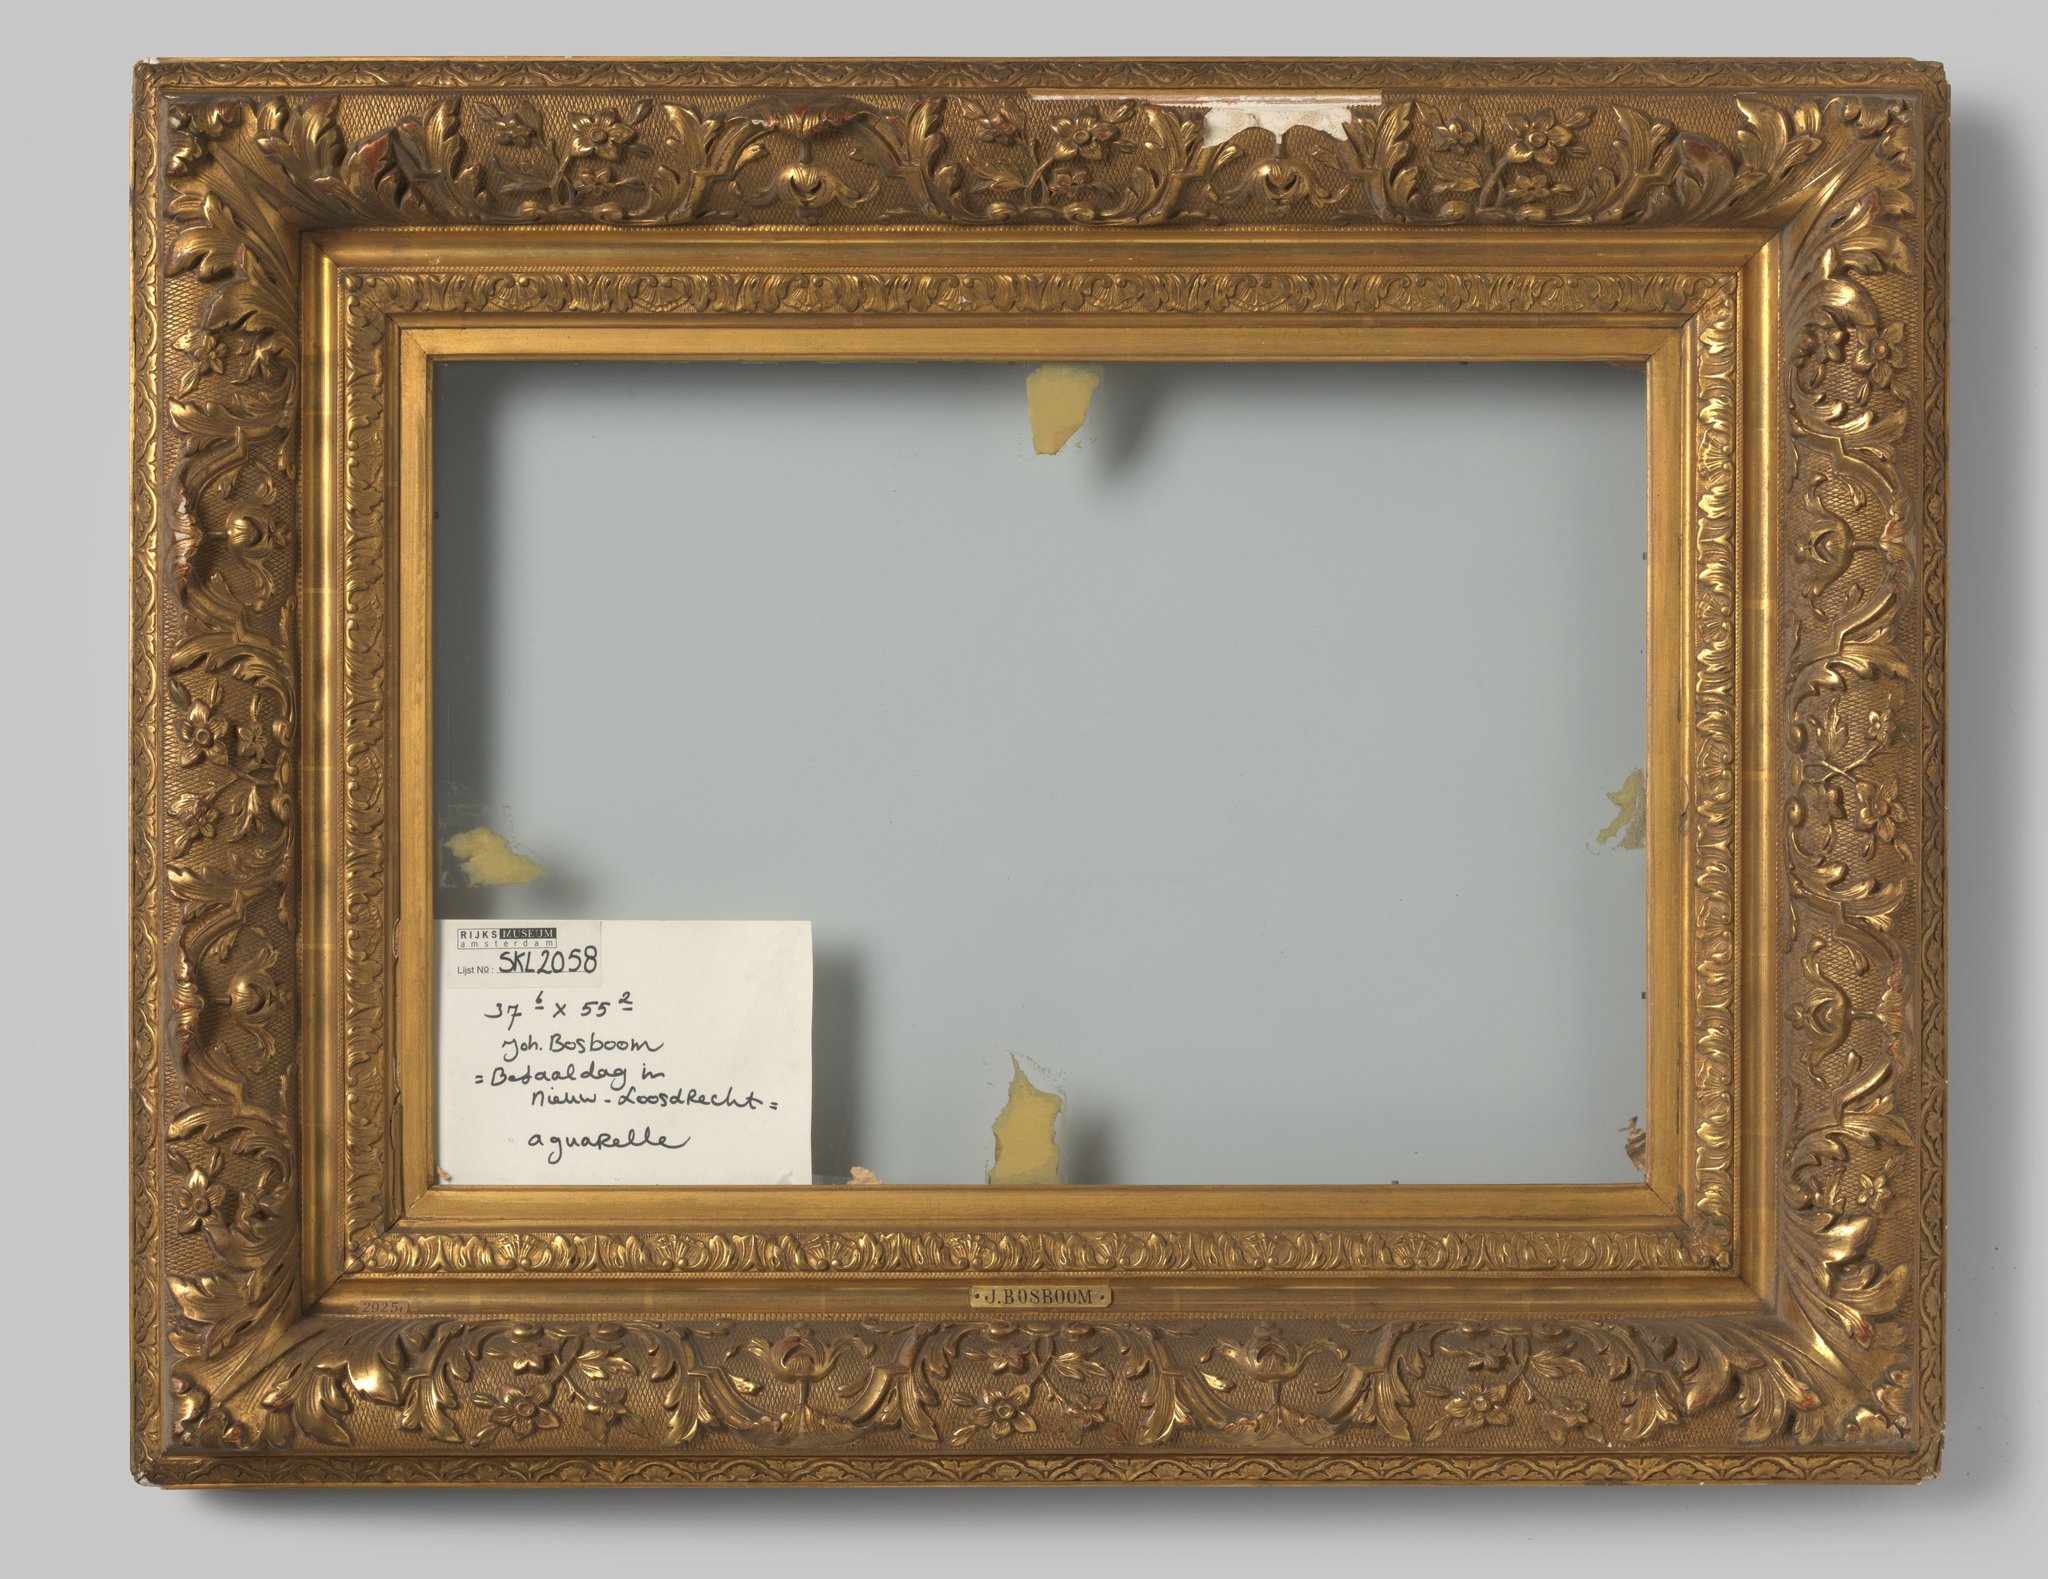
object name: frame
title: Vergulde lijst met pâte-ornamenten in Lodewijk XIII stijl (verenlijst).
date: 1800-1899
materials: gold leaf, wood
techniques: gilding